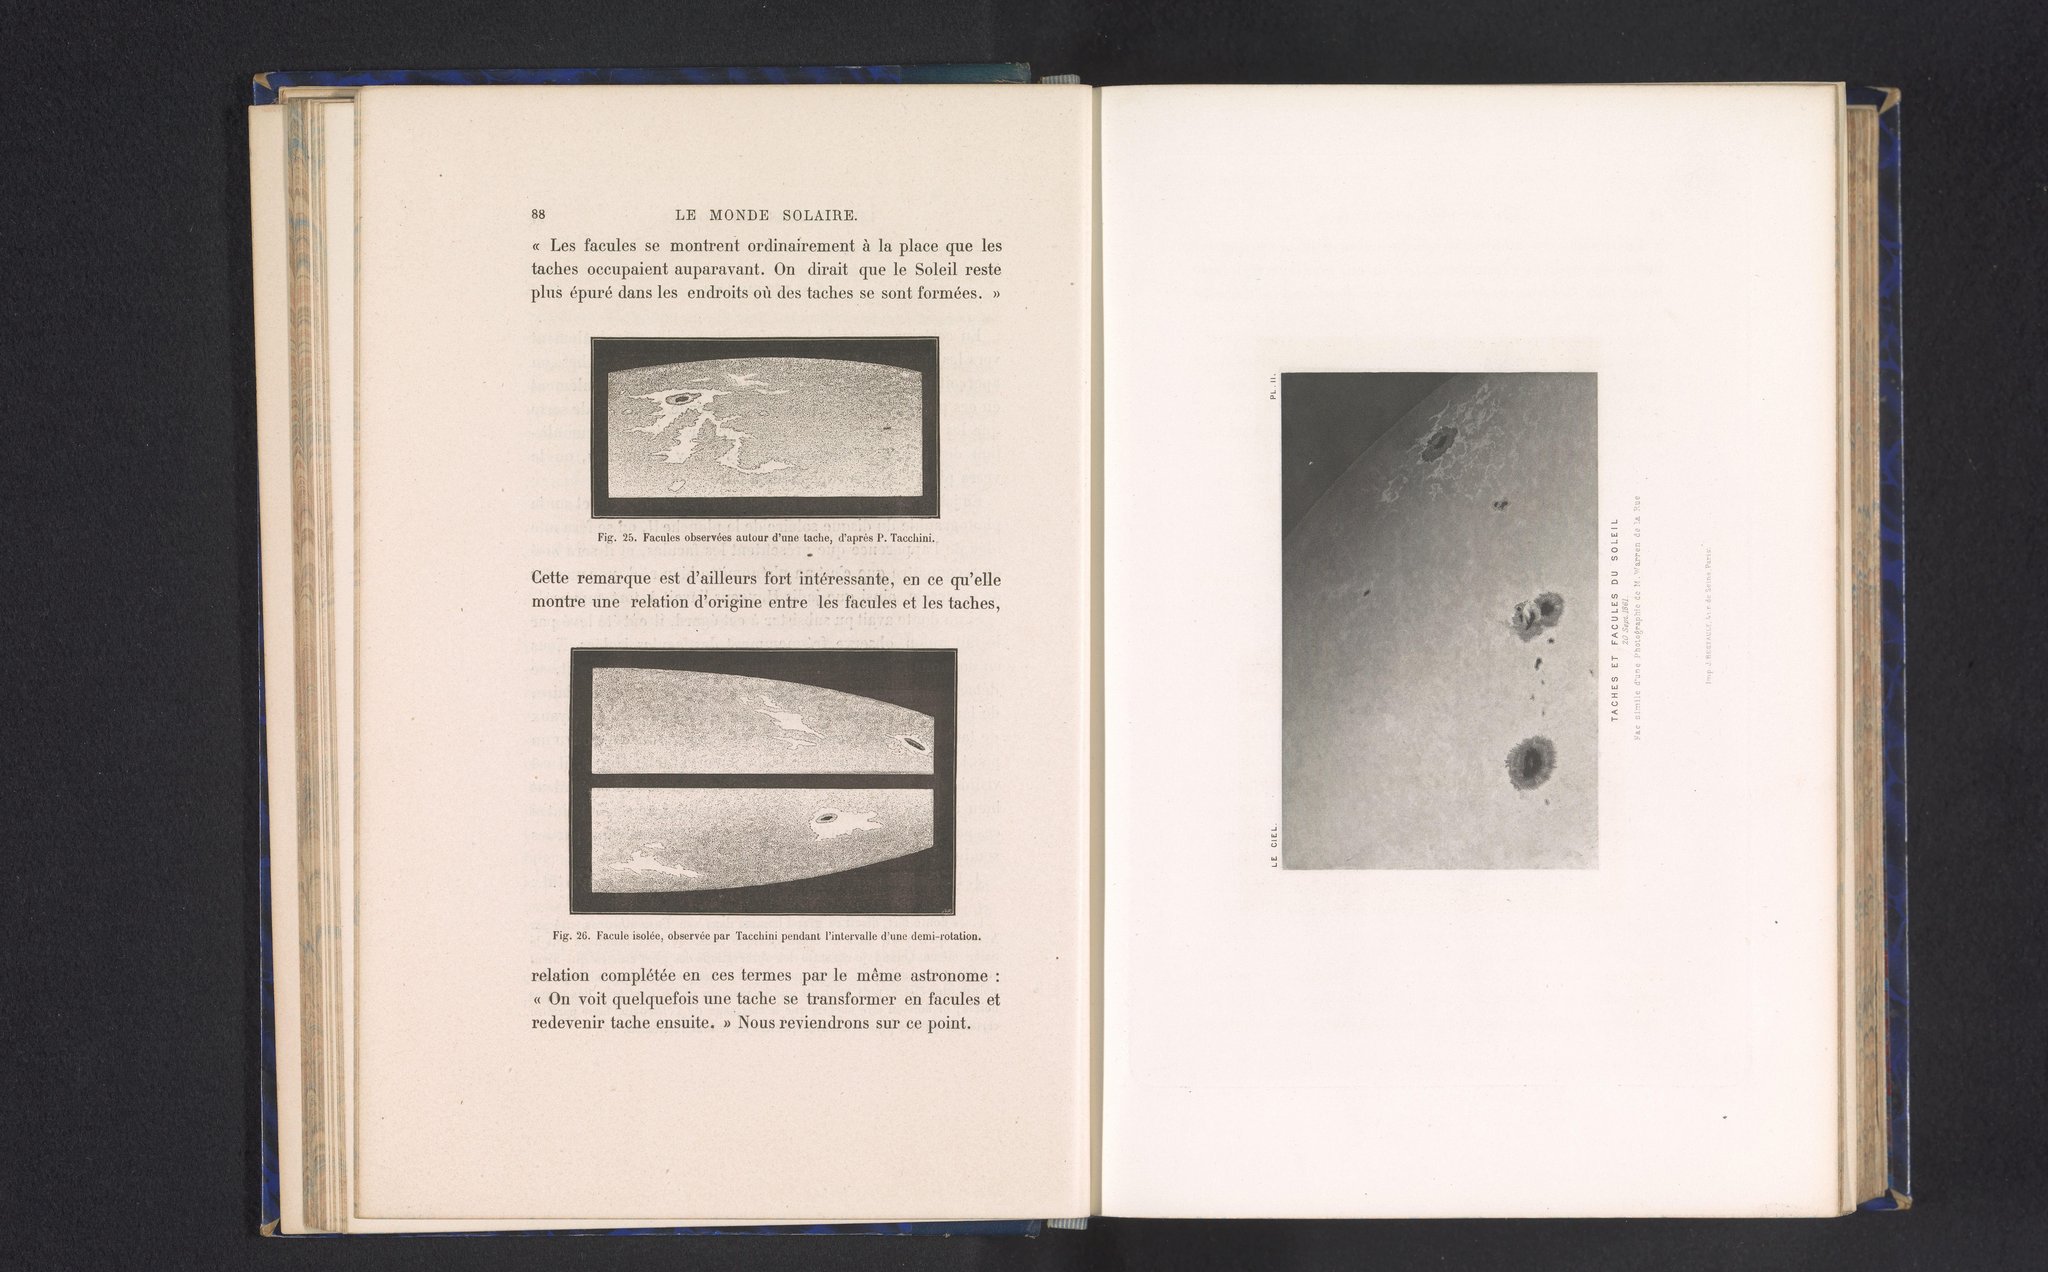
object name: photomechanical print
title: Vlekken en zonnefakkels op het oppervlak van de zon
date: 1867-1877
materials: paper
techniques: photoaquatint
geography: paris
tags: sun-spots, sun as celestial body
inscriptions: number: ‘Pl. II.’, inscription: ‘20 Sept. 1861.’